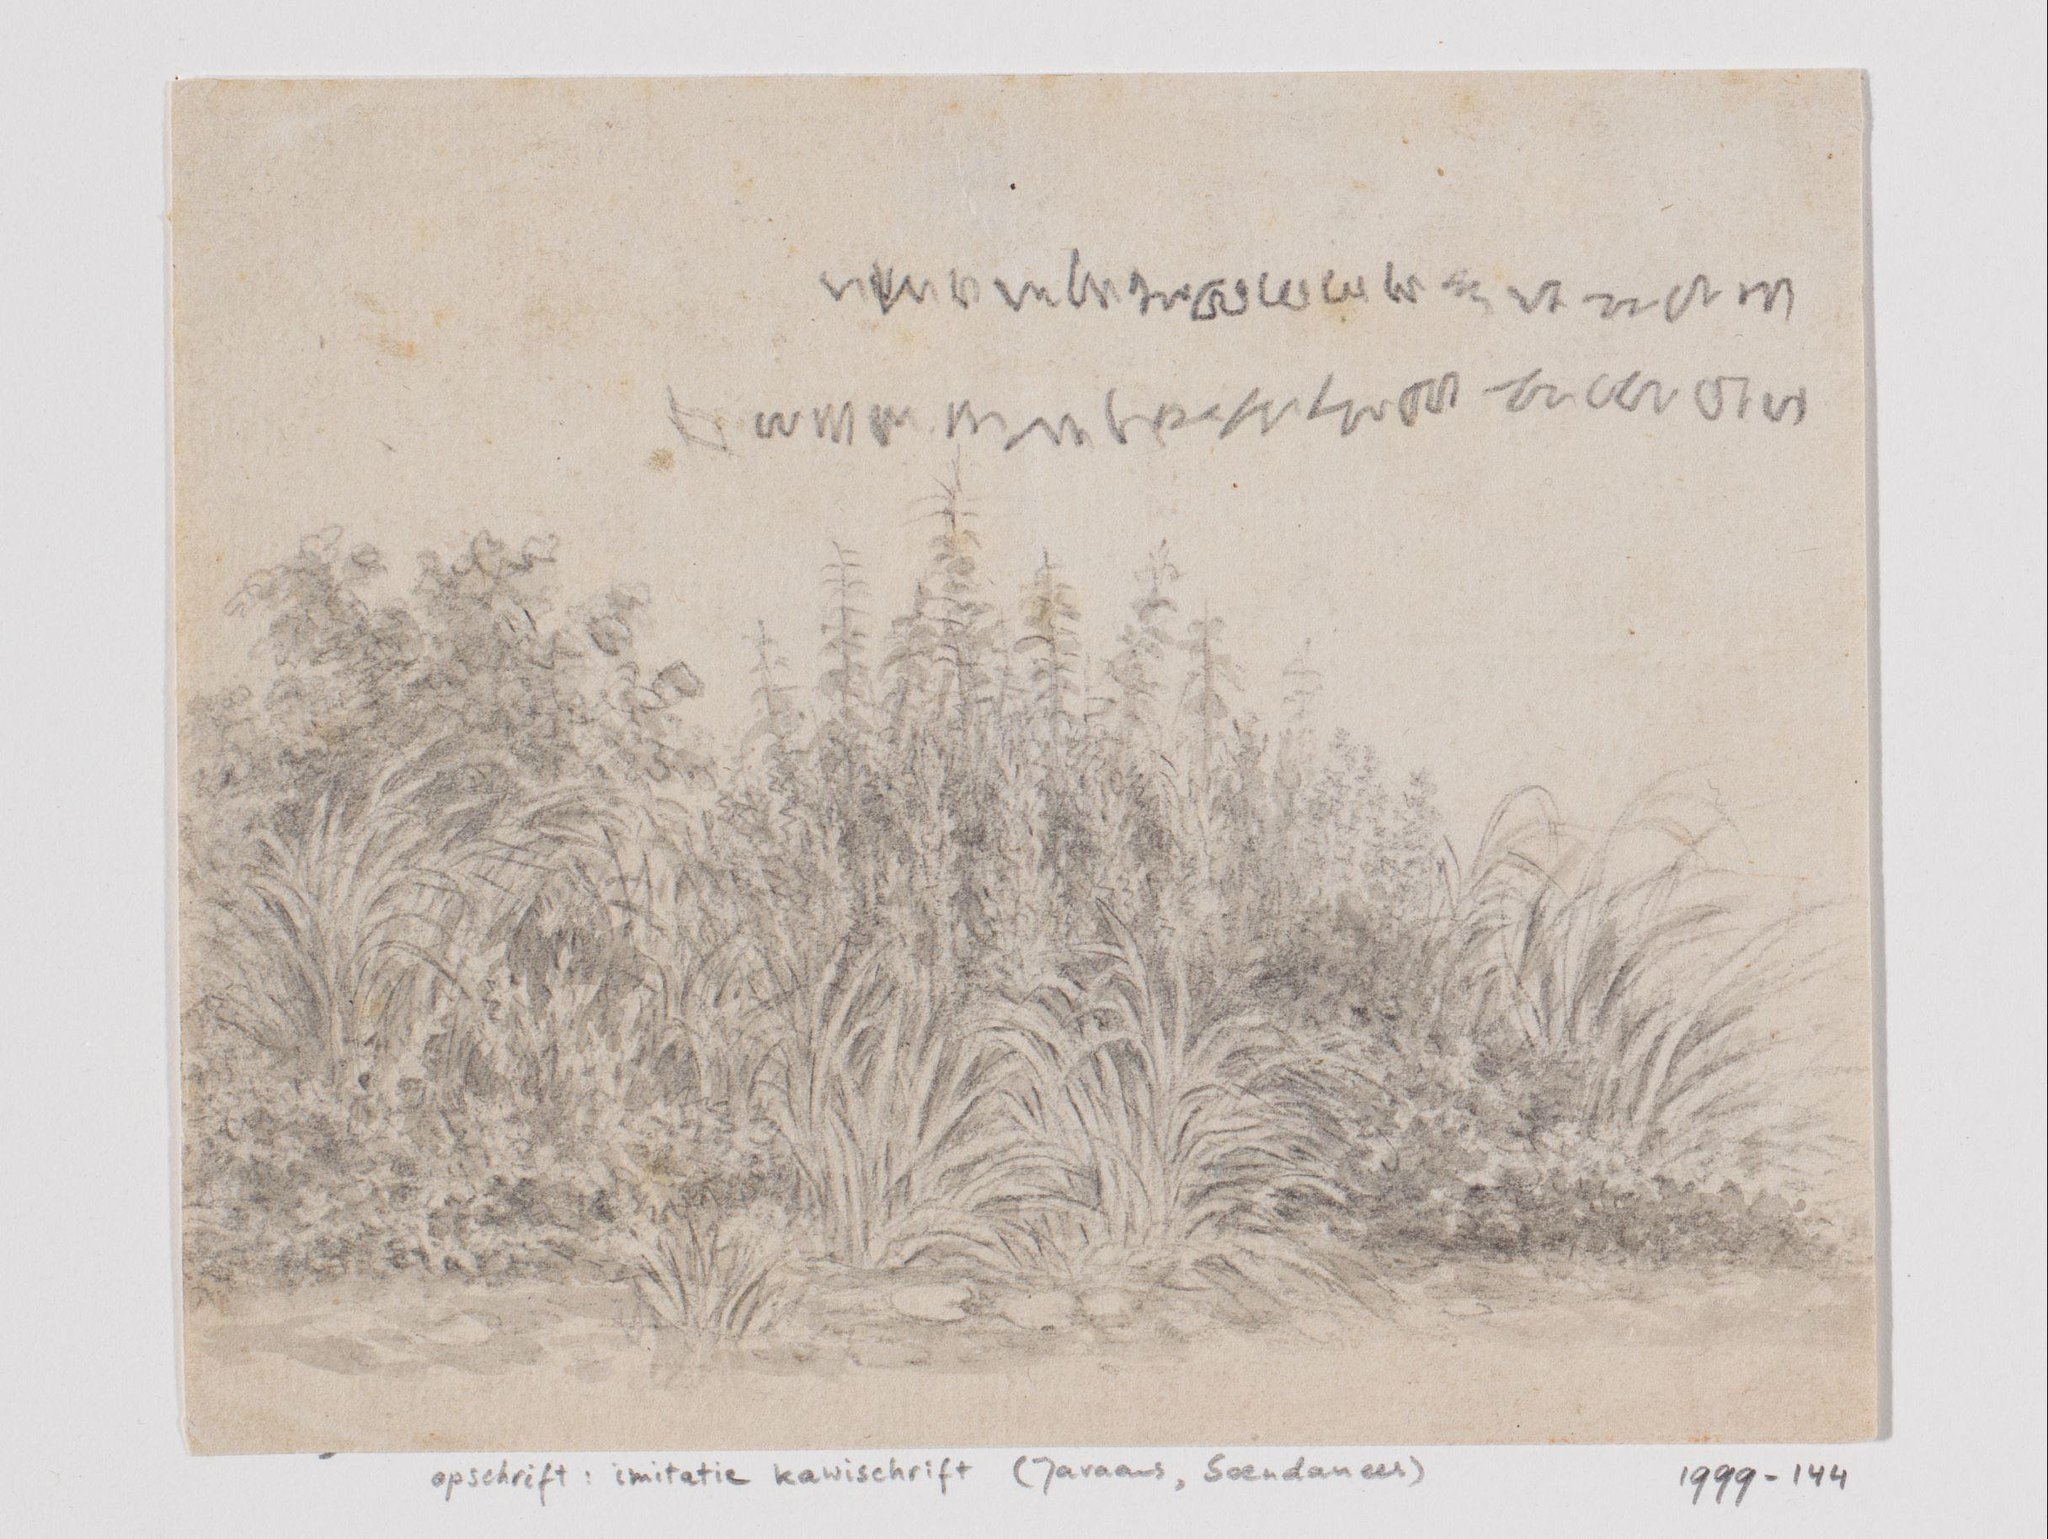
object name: drawing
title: Struiken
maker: adrianus johannes bik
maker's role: draughtsman, print maker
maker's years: 1790-1872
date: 1816-1846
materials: chalk, paper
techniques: brush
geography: java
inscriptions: inscription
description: artikel over deze collectie in Bulletin van het Rijksmuseum 49 [2001], nr. 4, pp.343 e.v.